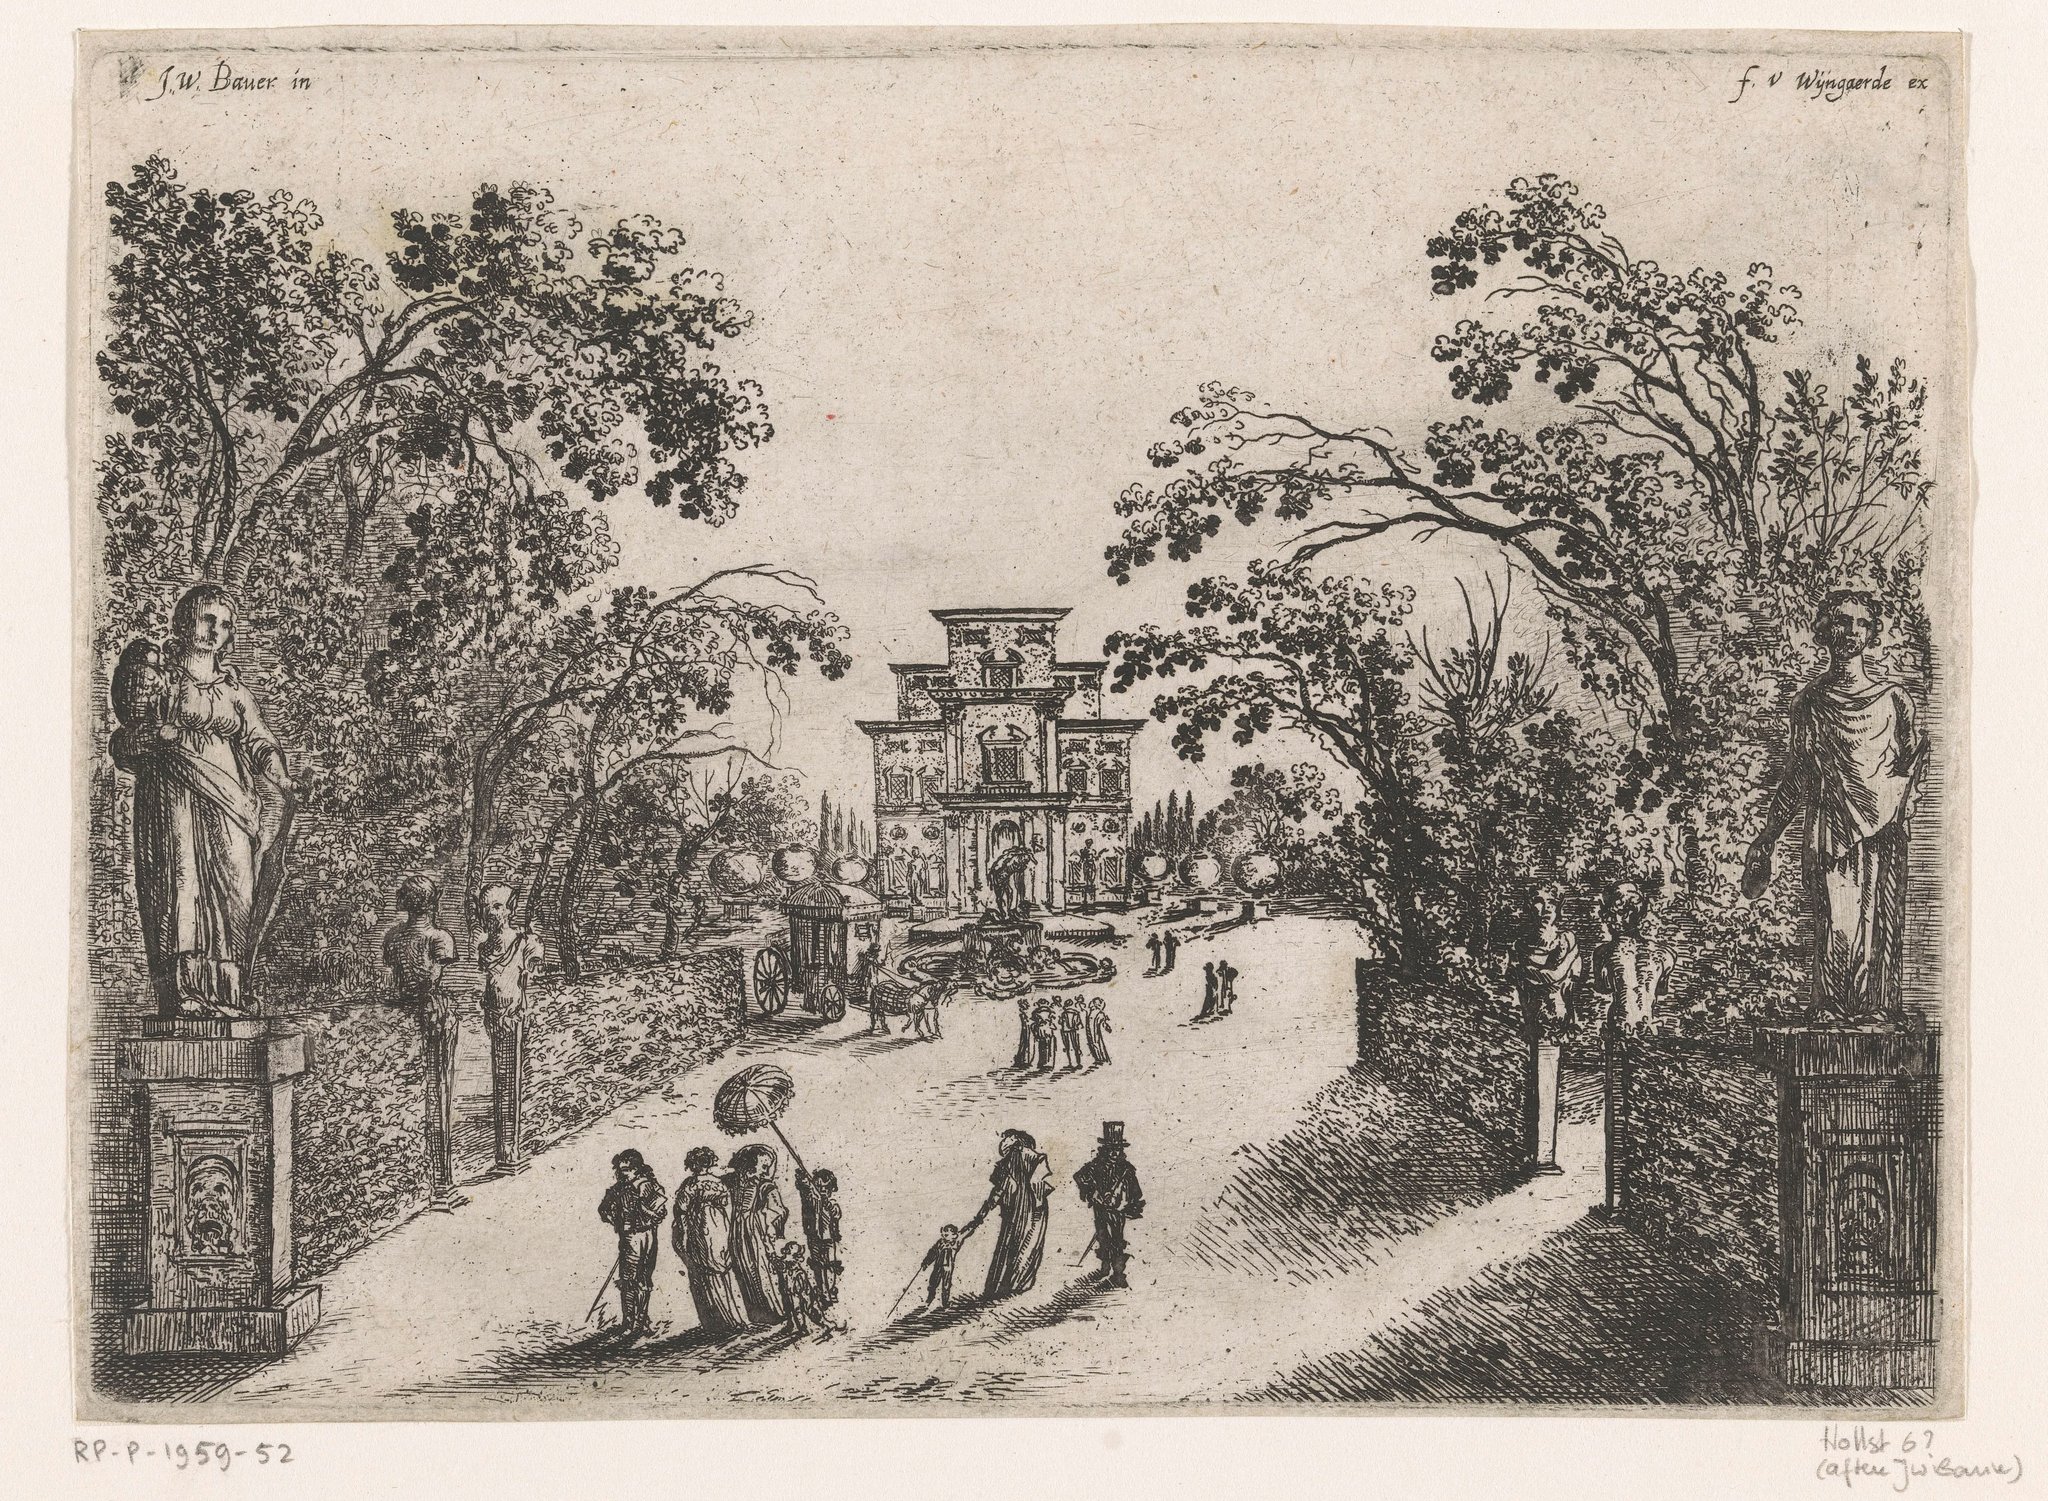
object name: print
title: Wandelende mensen in een park, een landhuis in de achtergrond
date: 1636-1679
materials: paper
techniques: etching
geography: antwerp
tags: four-wheeled vehicle drawn by one animal, park, strolling, garden fountain, villa, statues, sculptures in garden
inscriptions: collector's mark: Lugt 2228